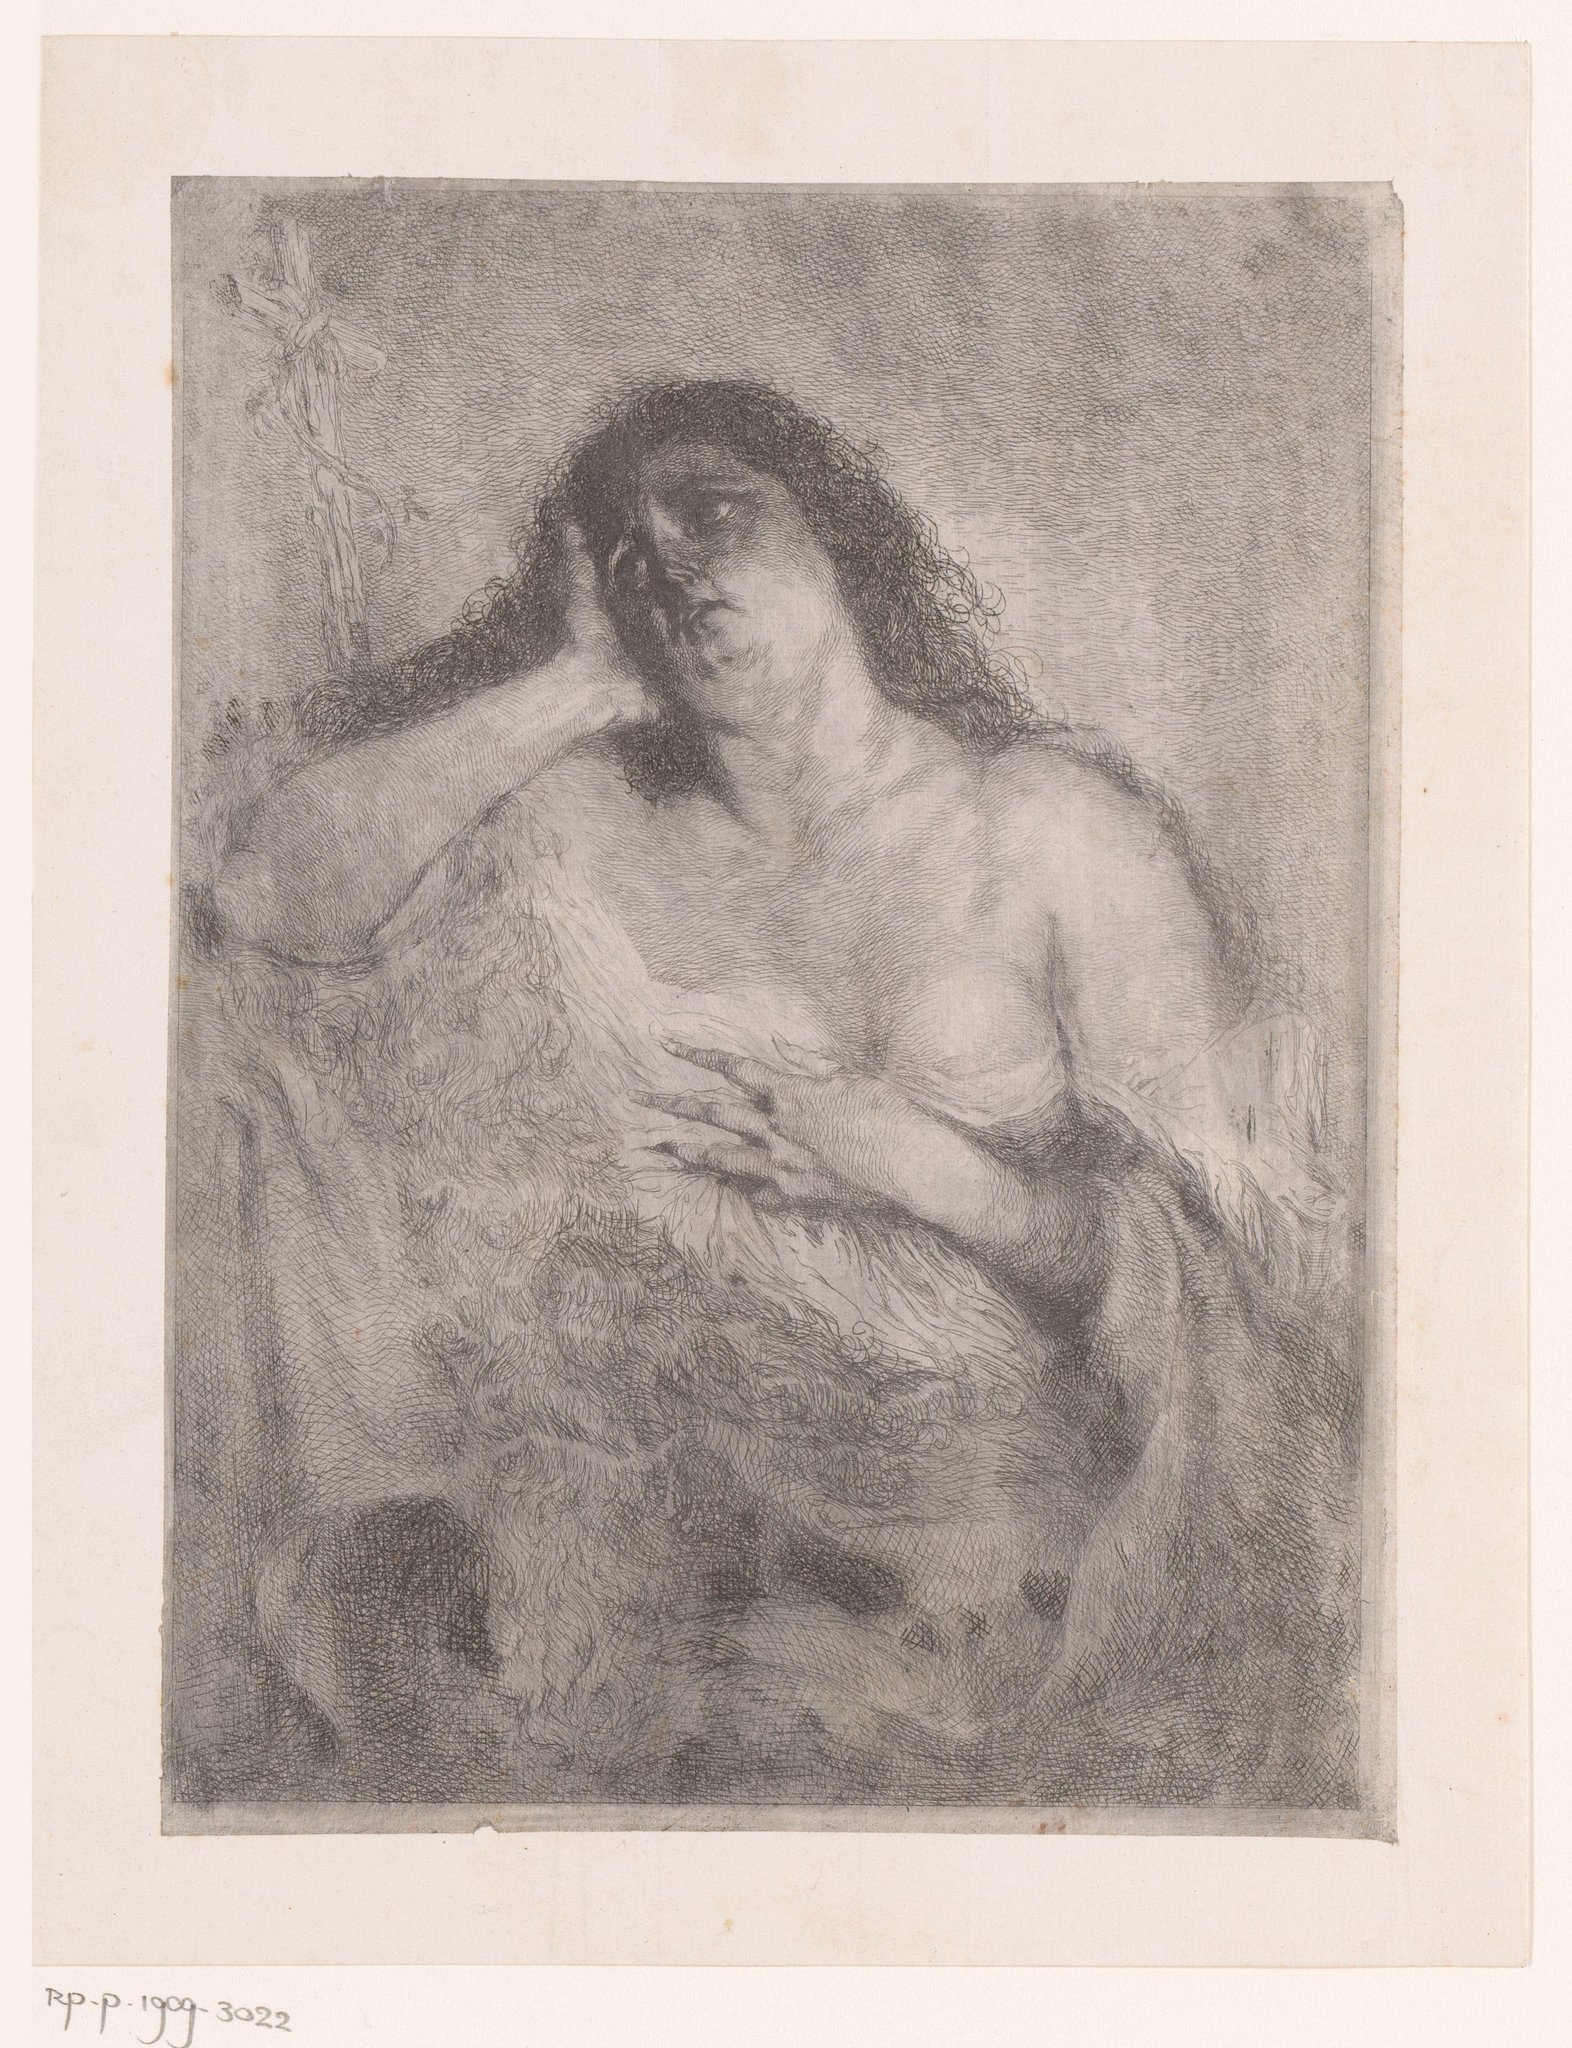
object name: print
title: Boetvaardige Maria Magdalena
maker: frédérique émile auguste oconnell-miethe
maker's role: print maker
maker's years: 1823-1885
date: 1833-1885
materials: paper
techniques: etching, intaglio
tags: the penitent harlot mary magdalene; possible attributes: book (or scroll), crown, crown of thorns, crucifix, jar of ointment, mirror, musical instrument, palm-branch, rosary, scourge - portrait of female saint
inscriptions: collector's mark: Lugt 2228, collector's mark: Lugt 1485